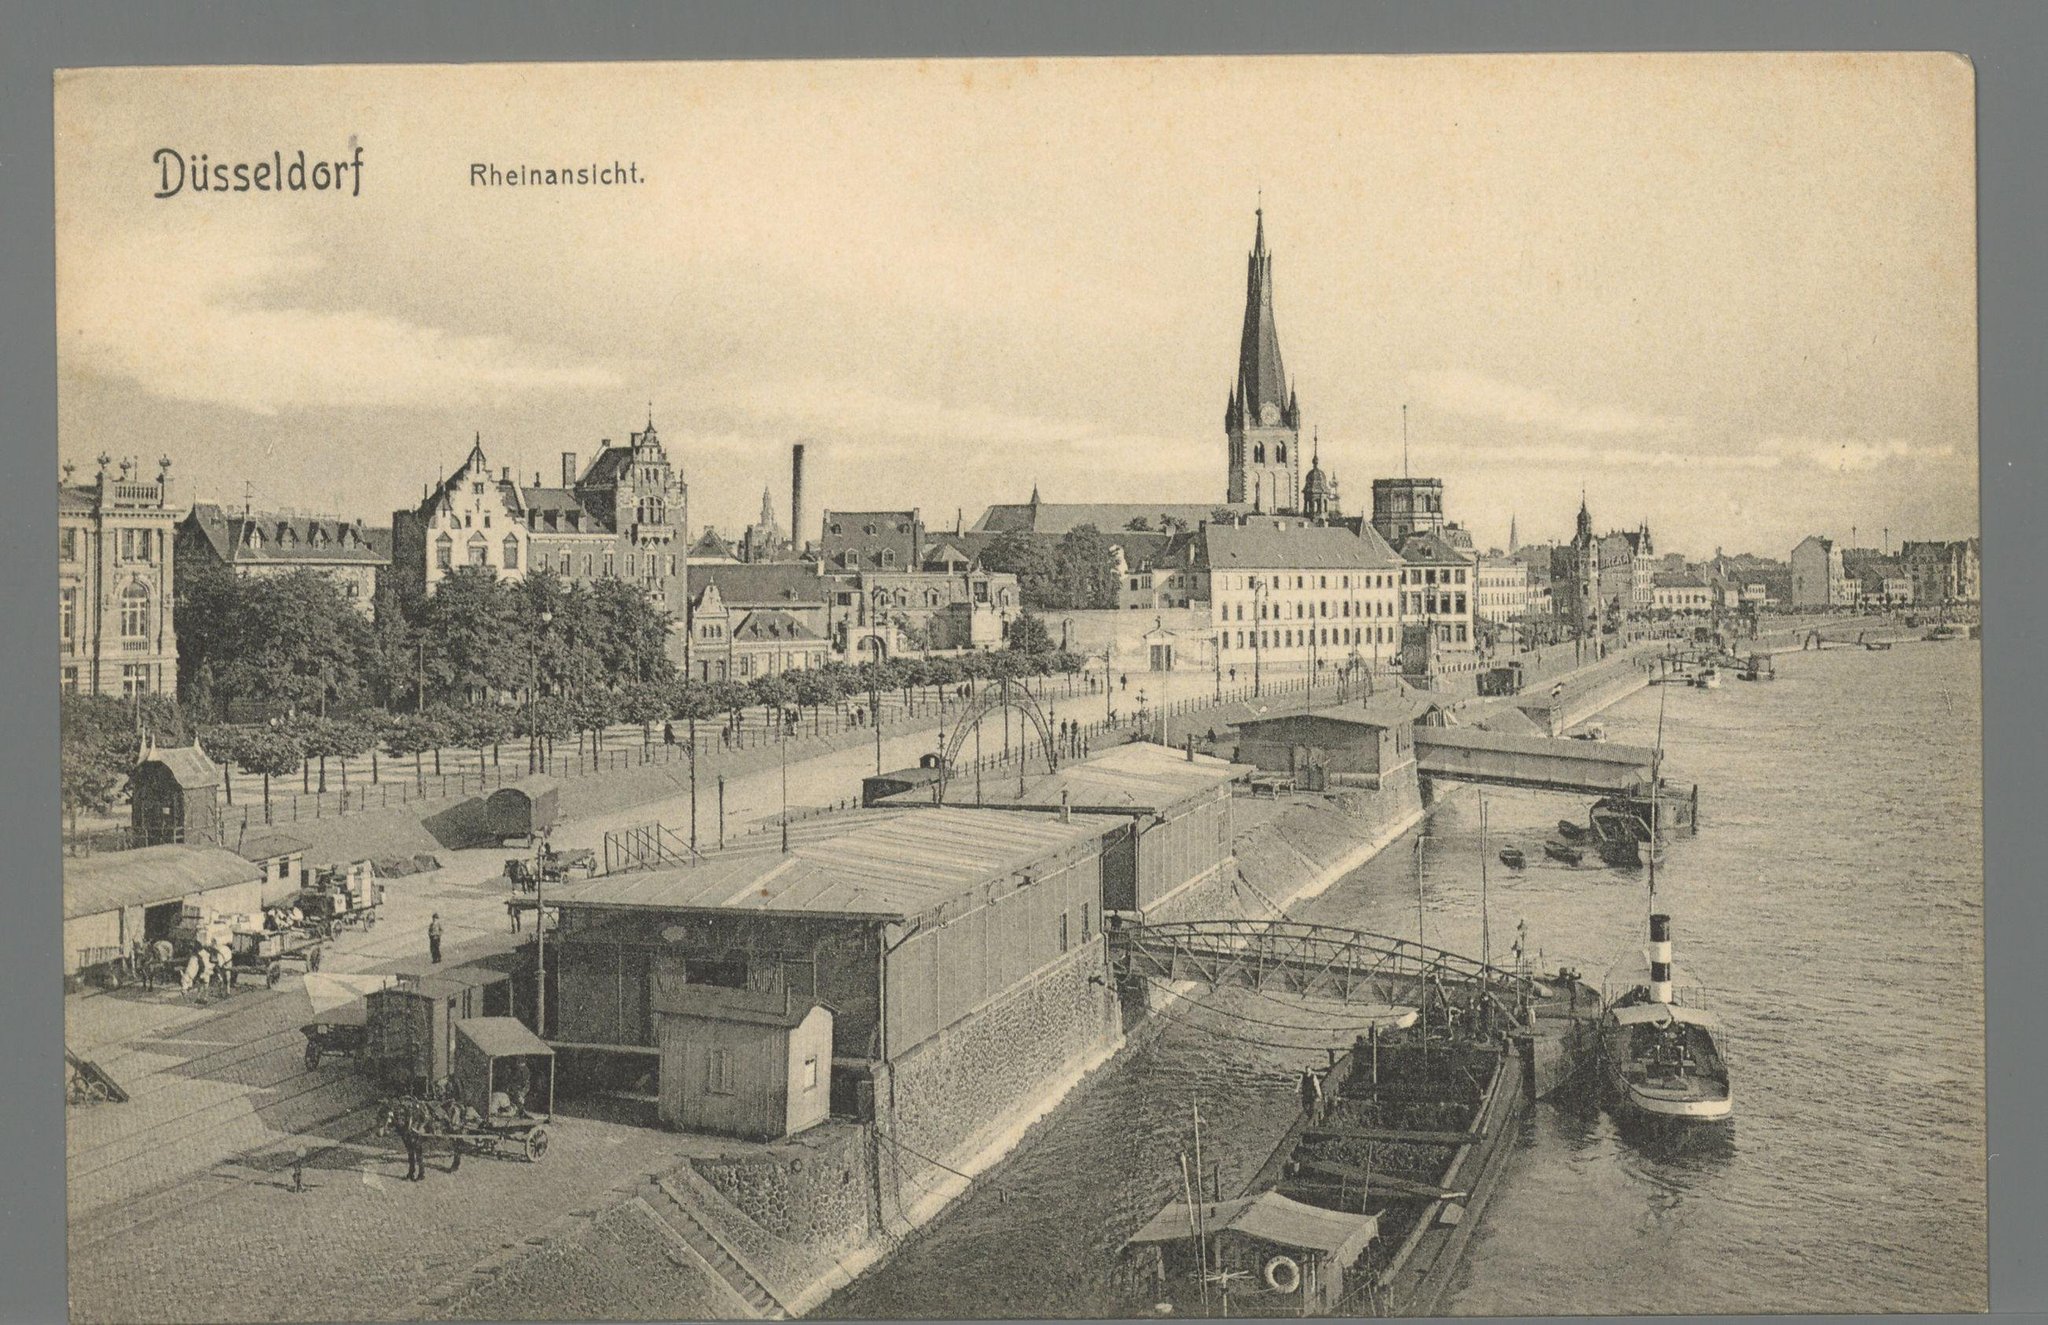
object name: photomechanical print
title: Düsseldorf. Rheinansicht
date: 1905-1930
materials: cardboard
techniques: photograph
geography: dusseldorf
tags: city-view, and landscape with man-made constructions, church (exterior), canals, waters (in city)